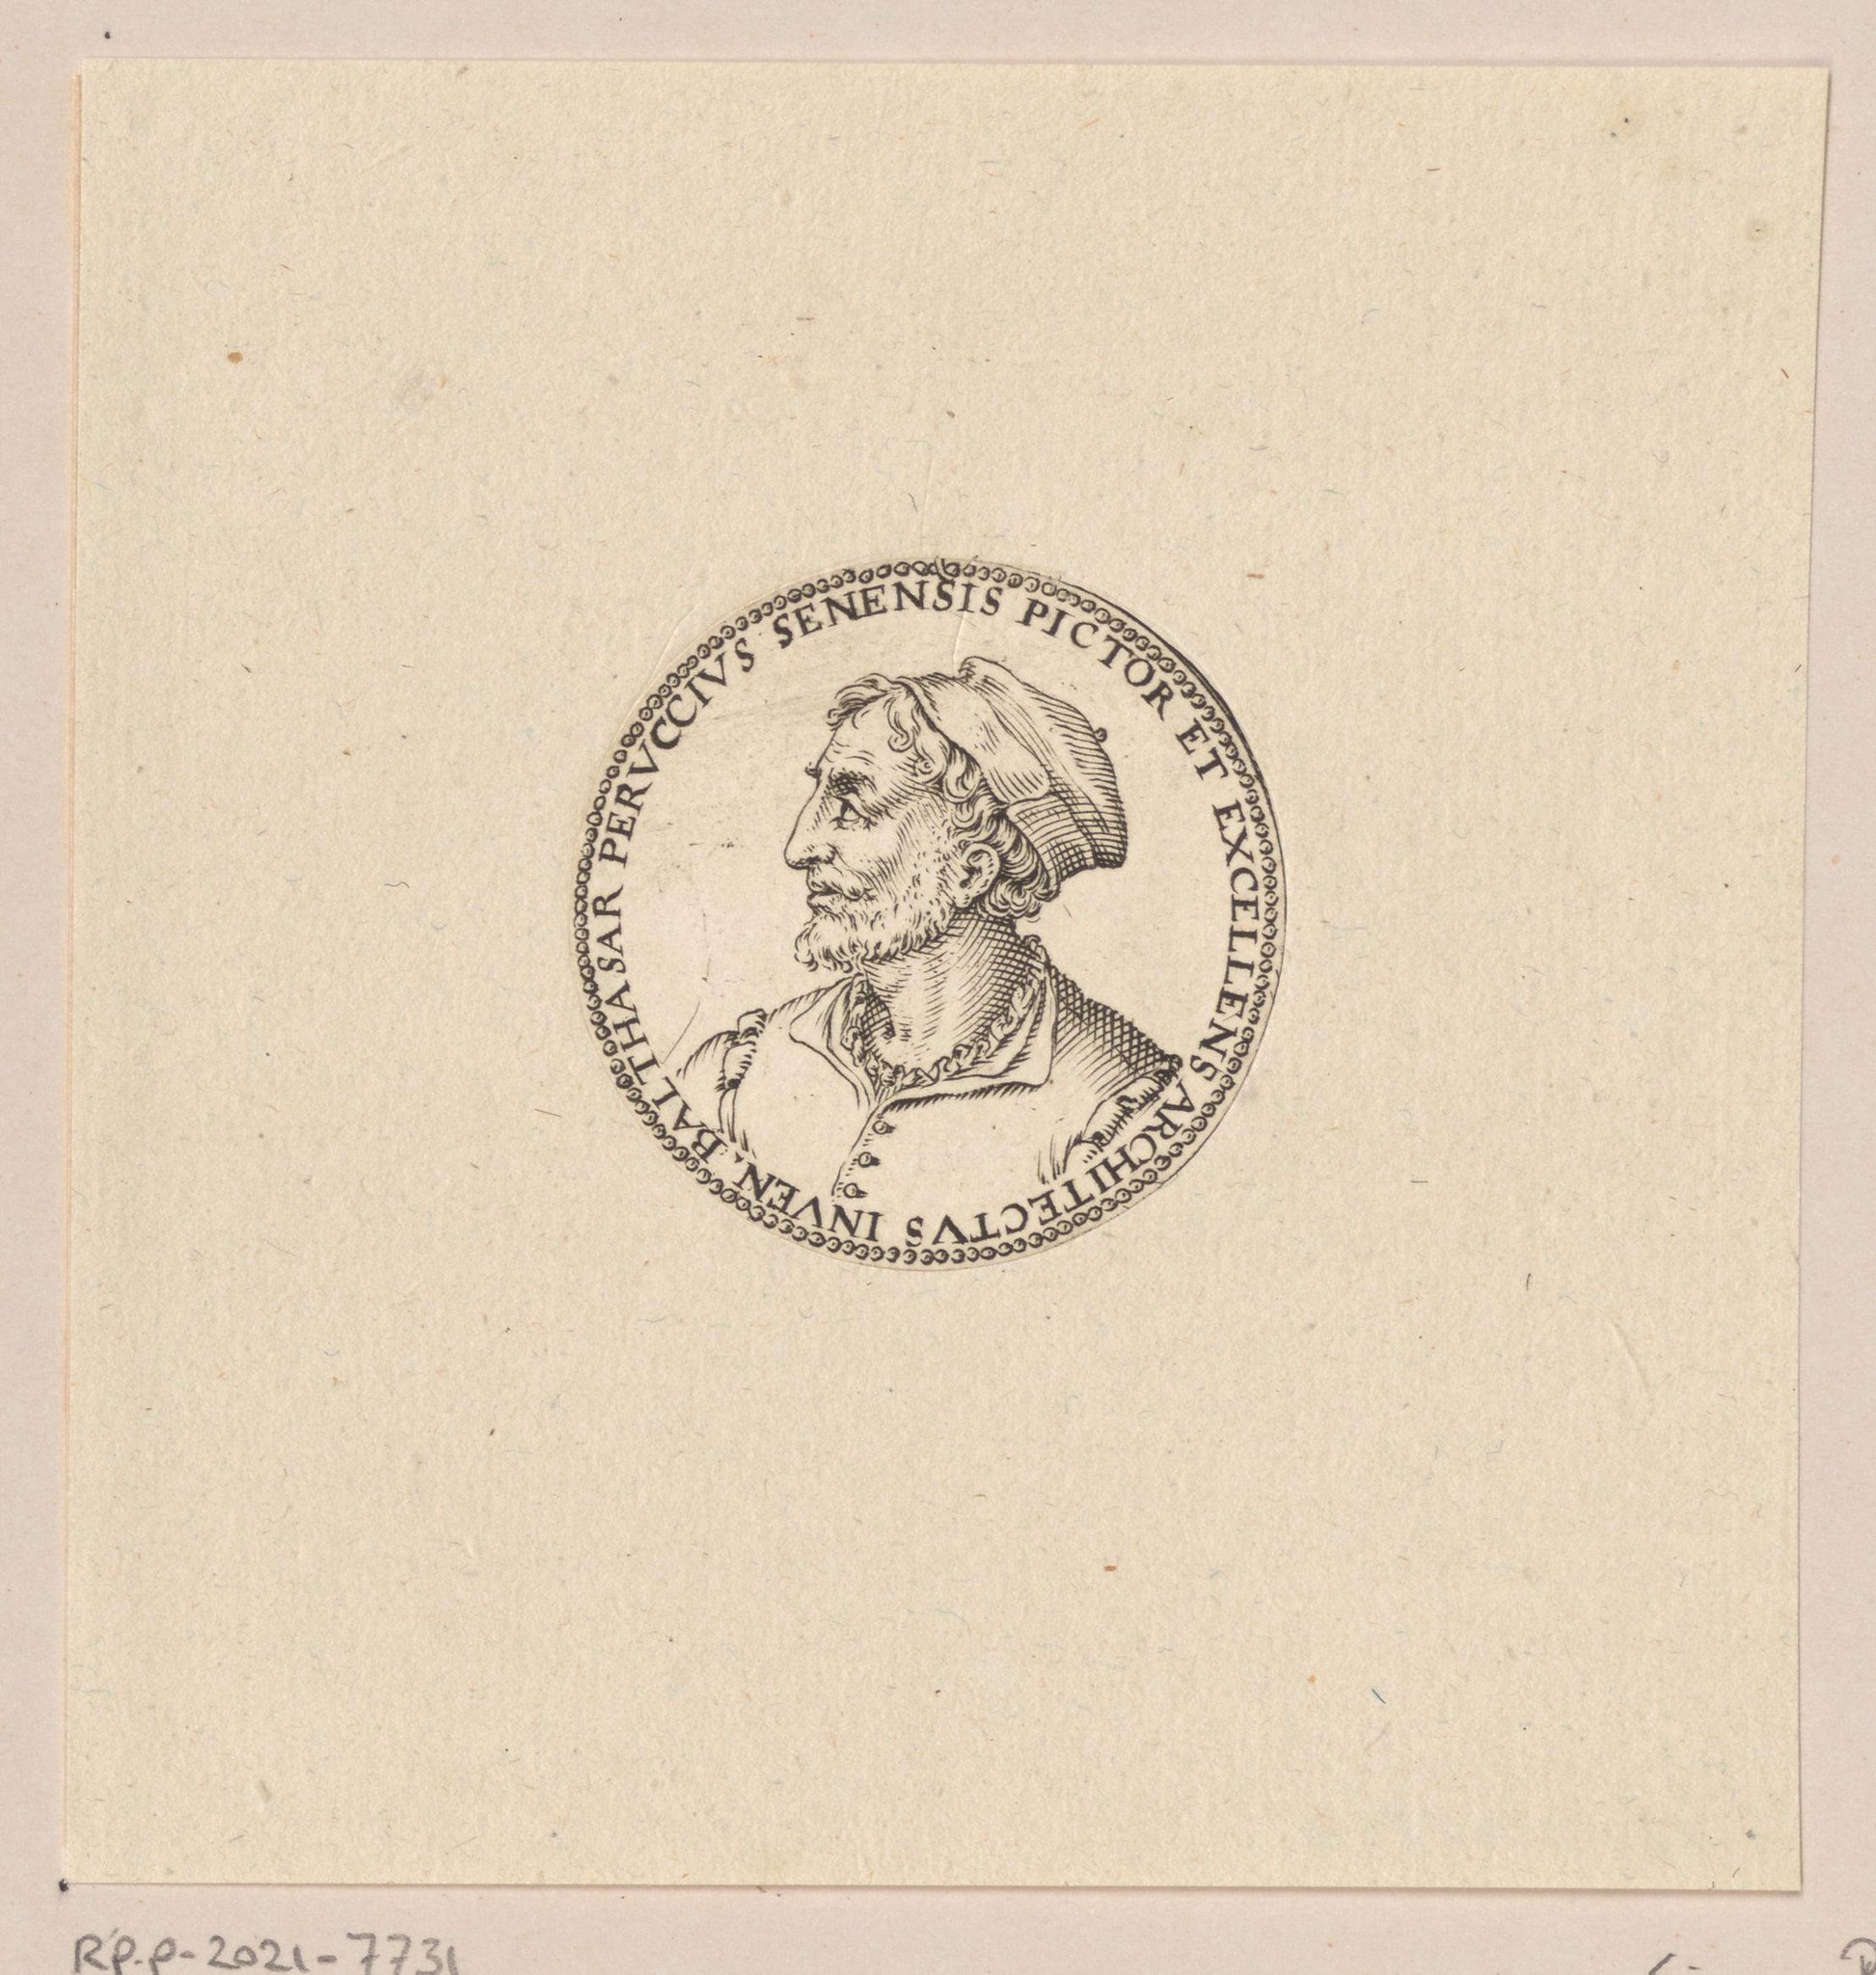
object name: print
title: Penning met het portret van Baldassare Peruzzi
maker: Anonymous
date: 1675-1749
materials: paper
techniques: engraving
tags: rome, painter, draughtsman, baldassare peruzzi, adult man, historical persons, coin